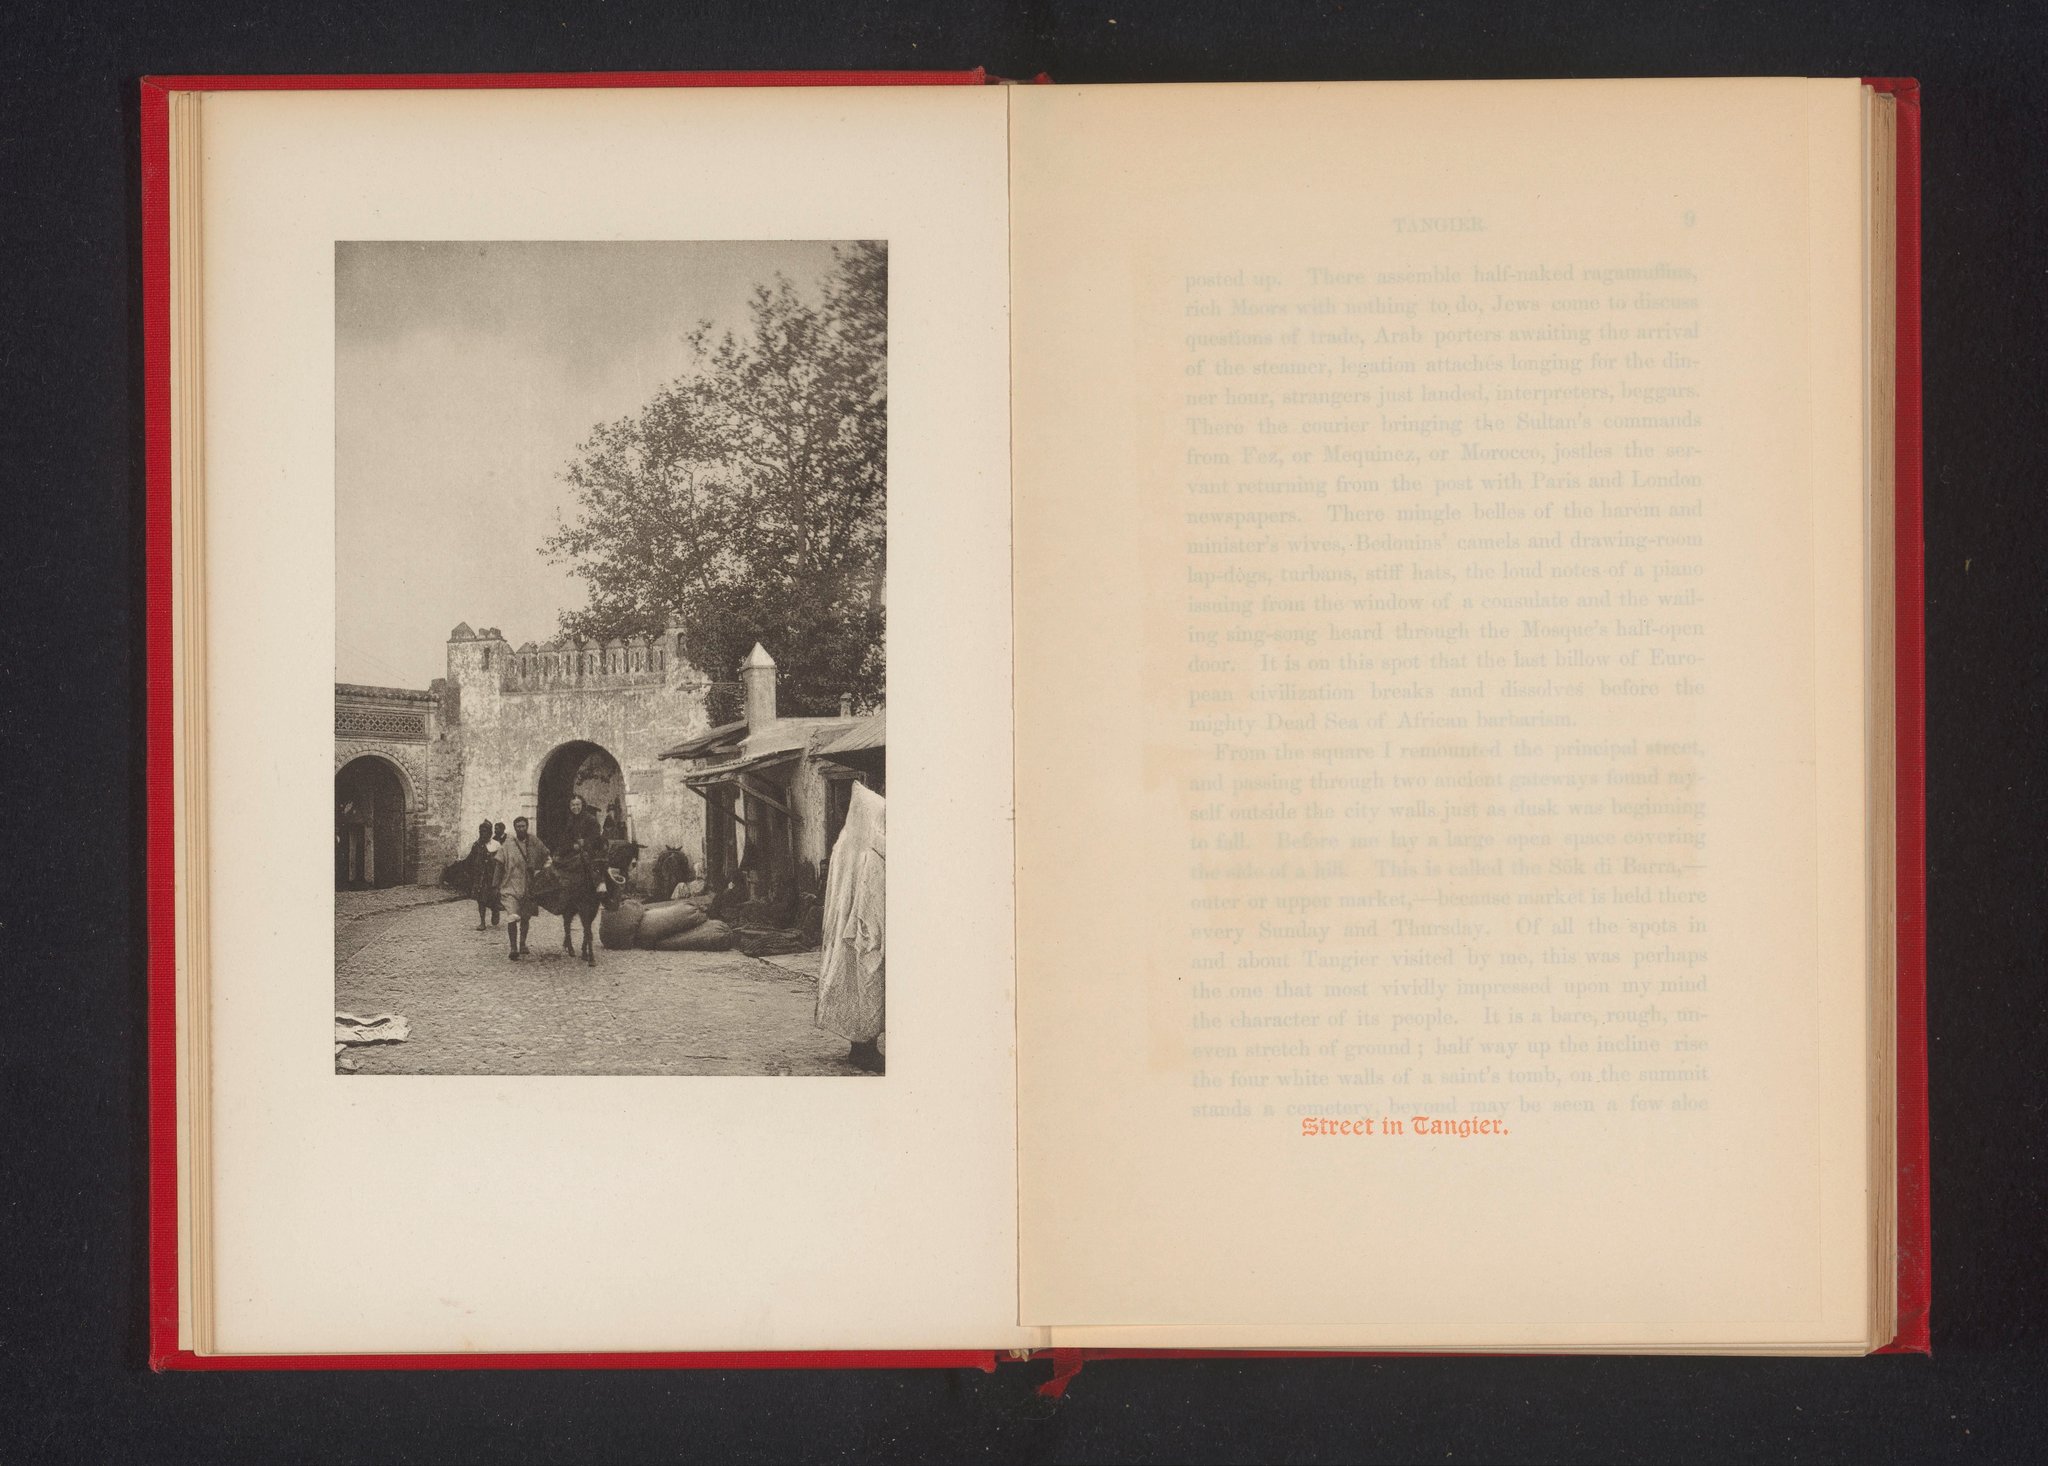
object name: photomechanical print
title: Straat te Tanger, met op de voorgrond een vrouw op een ezel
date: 1887-1897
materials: paper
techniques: photoaquatint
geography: tanger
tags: ass, donkey, street, city-gate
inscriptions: title: ‘Street in Tangier.’